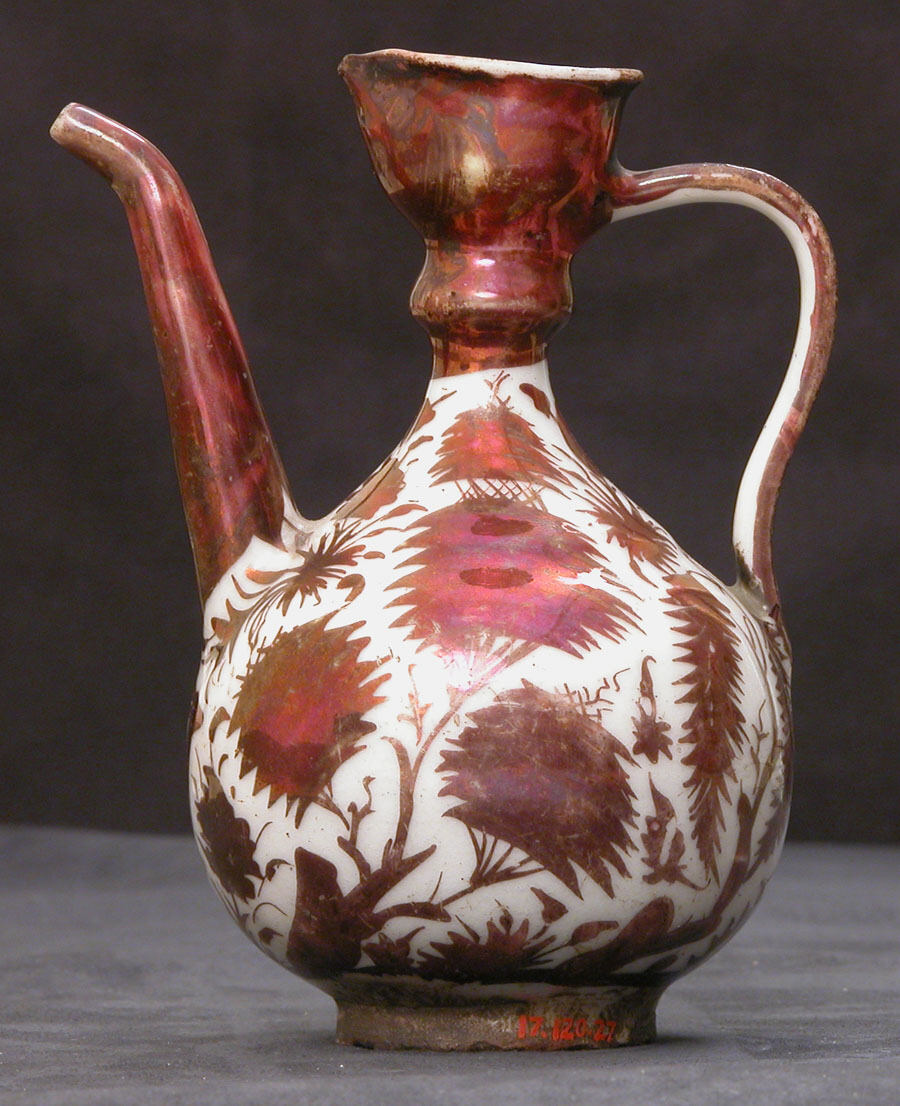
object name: ewer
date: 1601-1700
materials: glaze, stonepaste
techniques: luster painting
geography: iran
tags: leaves